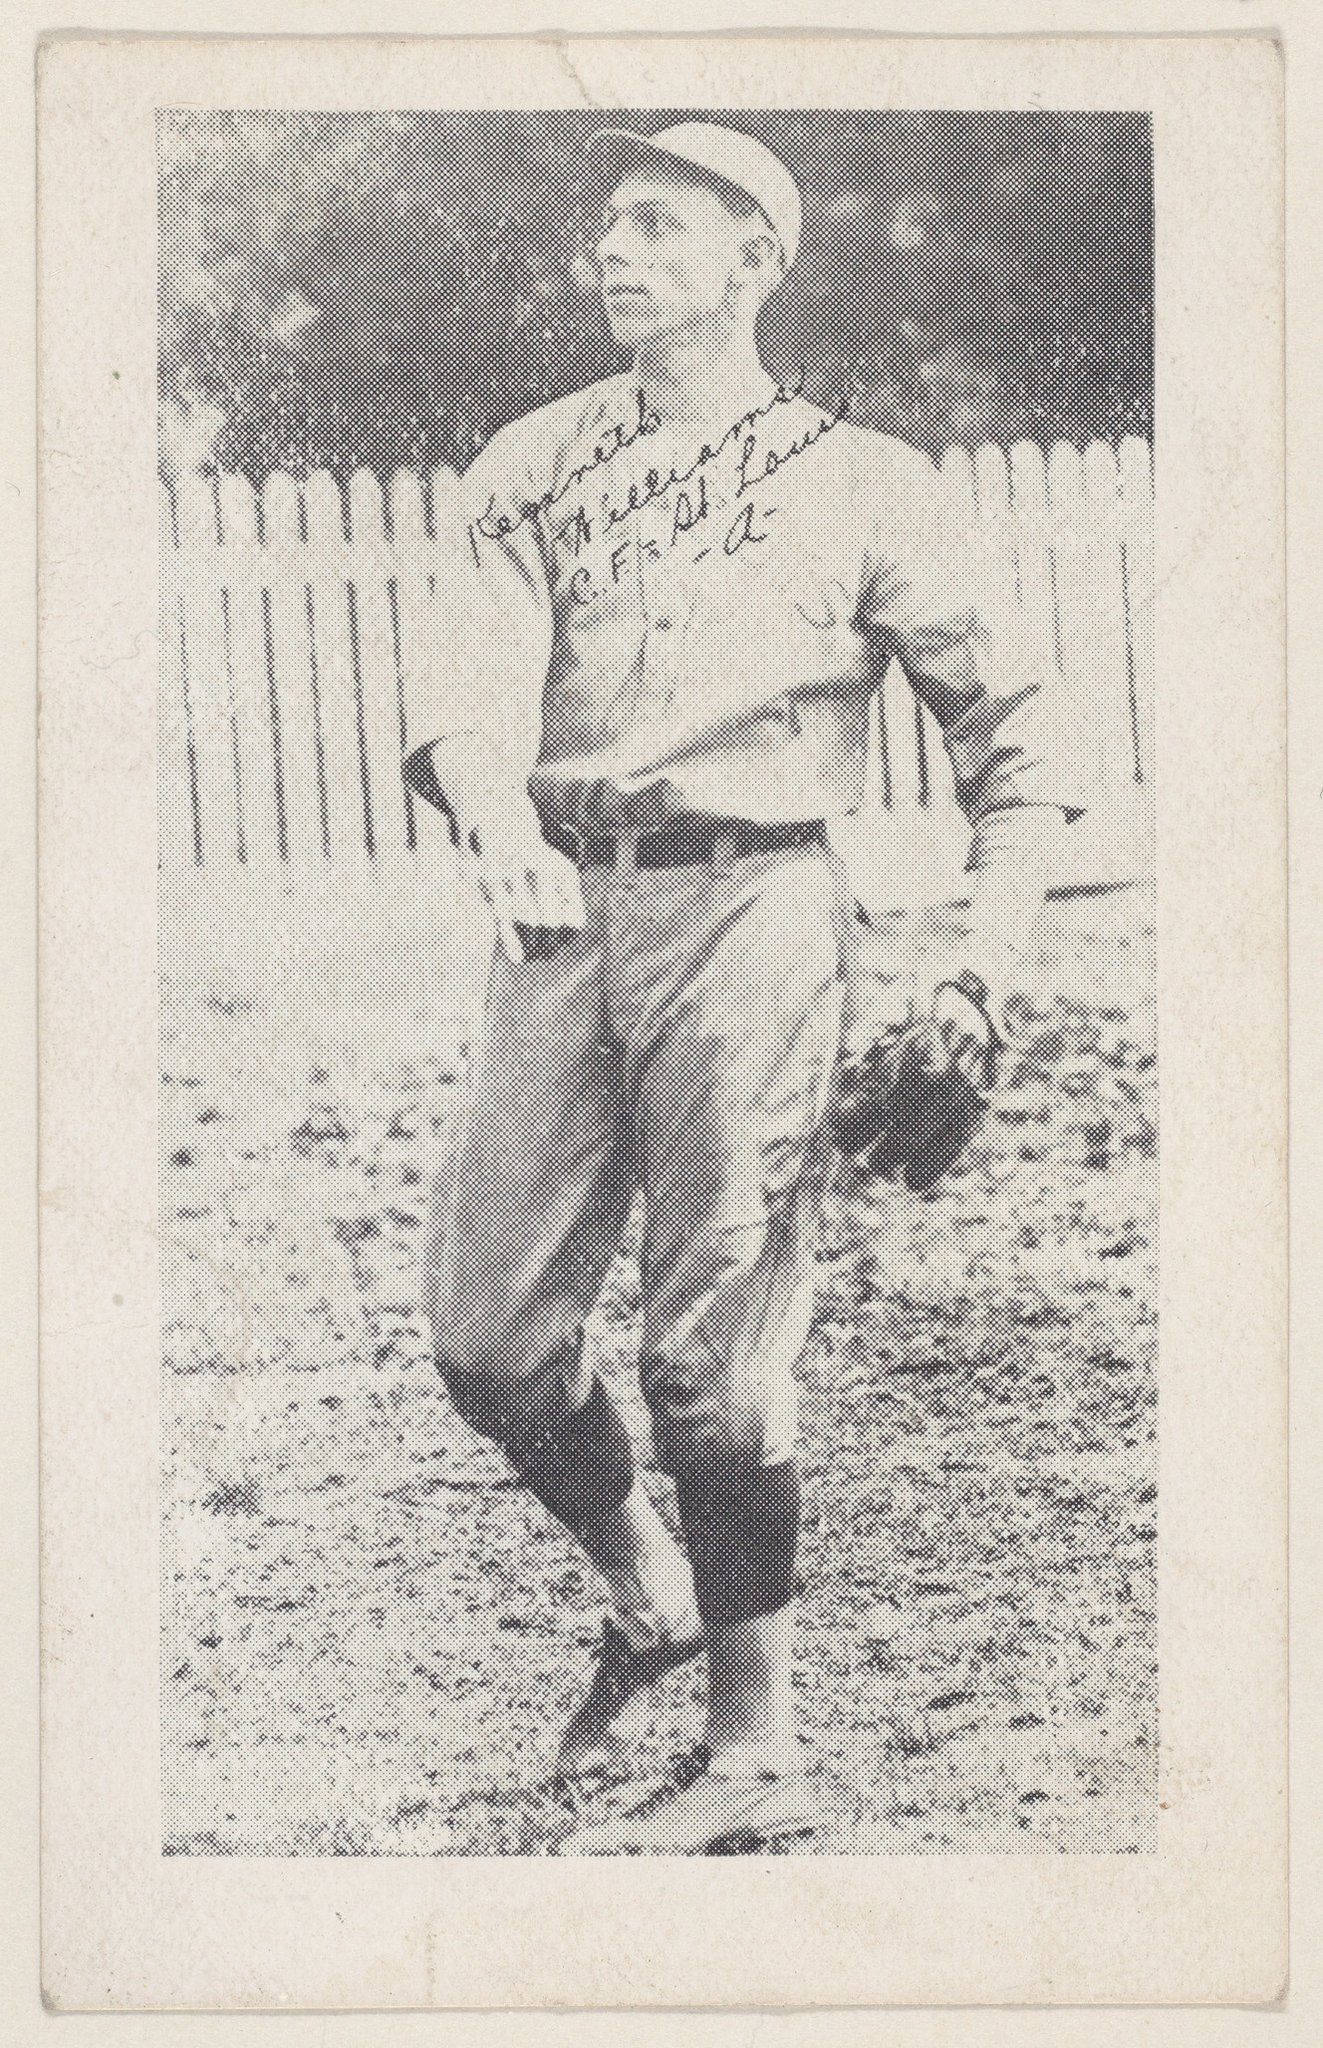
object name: print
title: Kenneth Williams, C.F.- St. Louis, A, from Baseball strip cards (W575-2)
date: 1921-1922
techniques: photolithograph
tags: men,portraits,baseball,athletes